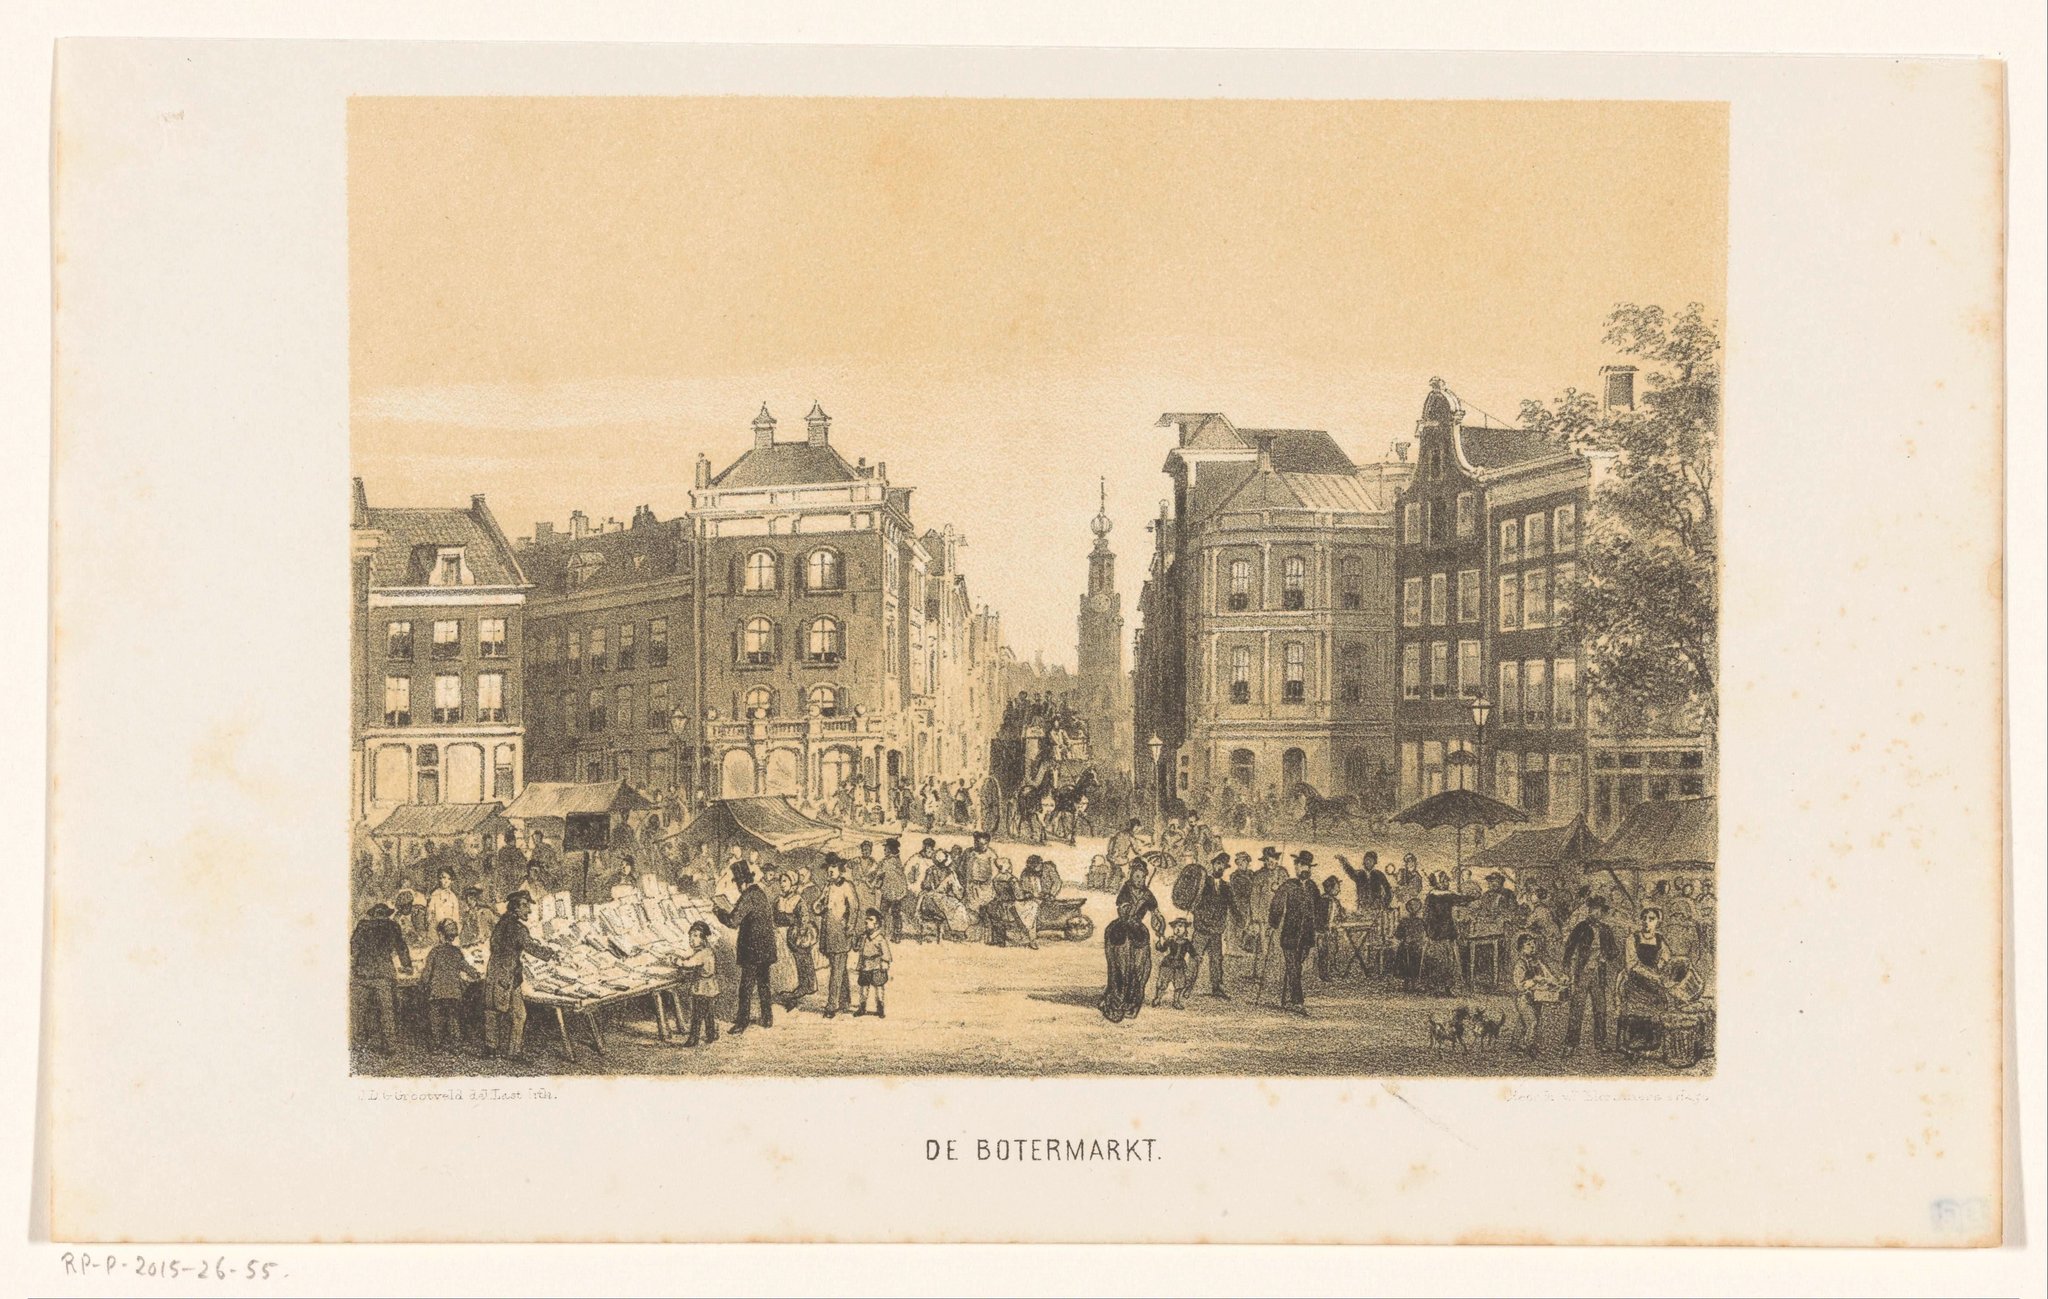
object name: print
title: De Botermarkt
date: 1875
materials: paper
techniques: tone lithography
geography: amsterdam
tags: diligence, omnibus, horse-tram, city-view in general; 'veduta' (+ city(-scape) with figures, staffage), book-shop, bookseller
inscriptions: collector's mark: Lugt 4780, collector's mark: Lugt 2228, collector's mark: Lugt 4779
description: Gezicht op de Botermarkt te Amsterdam, gezien naar de ingang van de Reguliersbreestraat. Op de voorgrond de kraam van een boekhandelaar, in de achtergrond een paardentram en doorkijk naar de Munttoren.